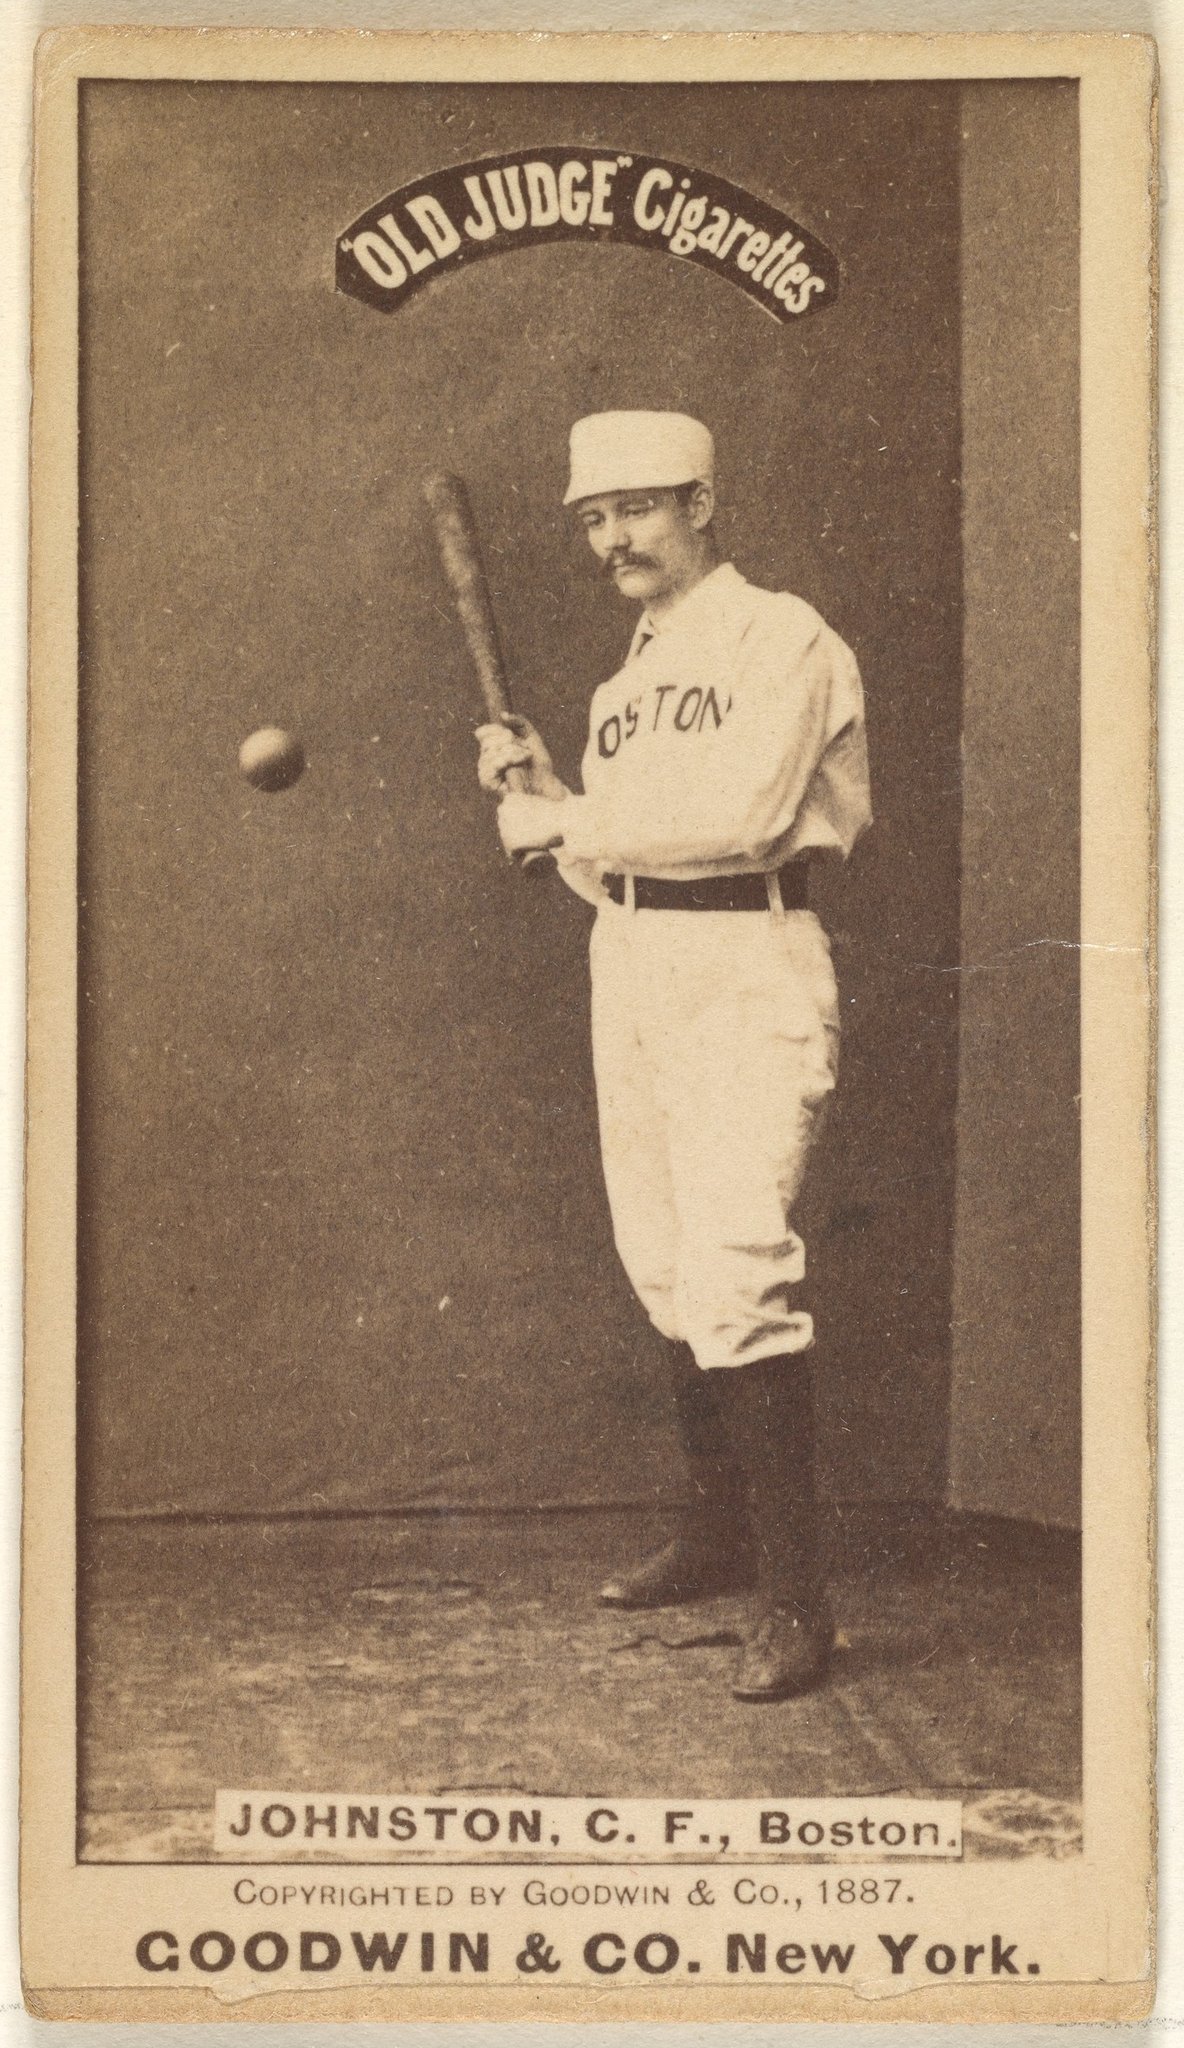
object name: baseball card, photograph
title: Johnston, Center Field, Boston, from the Old Judge series (N172) for Old Judge Cigarettes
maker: goodwin & company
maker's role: publisher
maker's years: 1850-1950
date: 1887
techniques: albumen silver print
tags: men,portraits,baseball,athletes